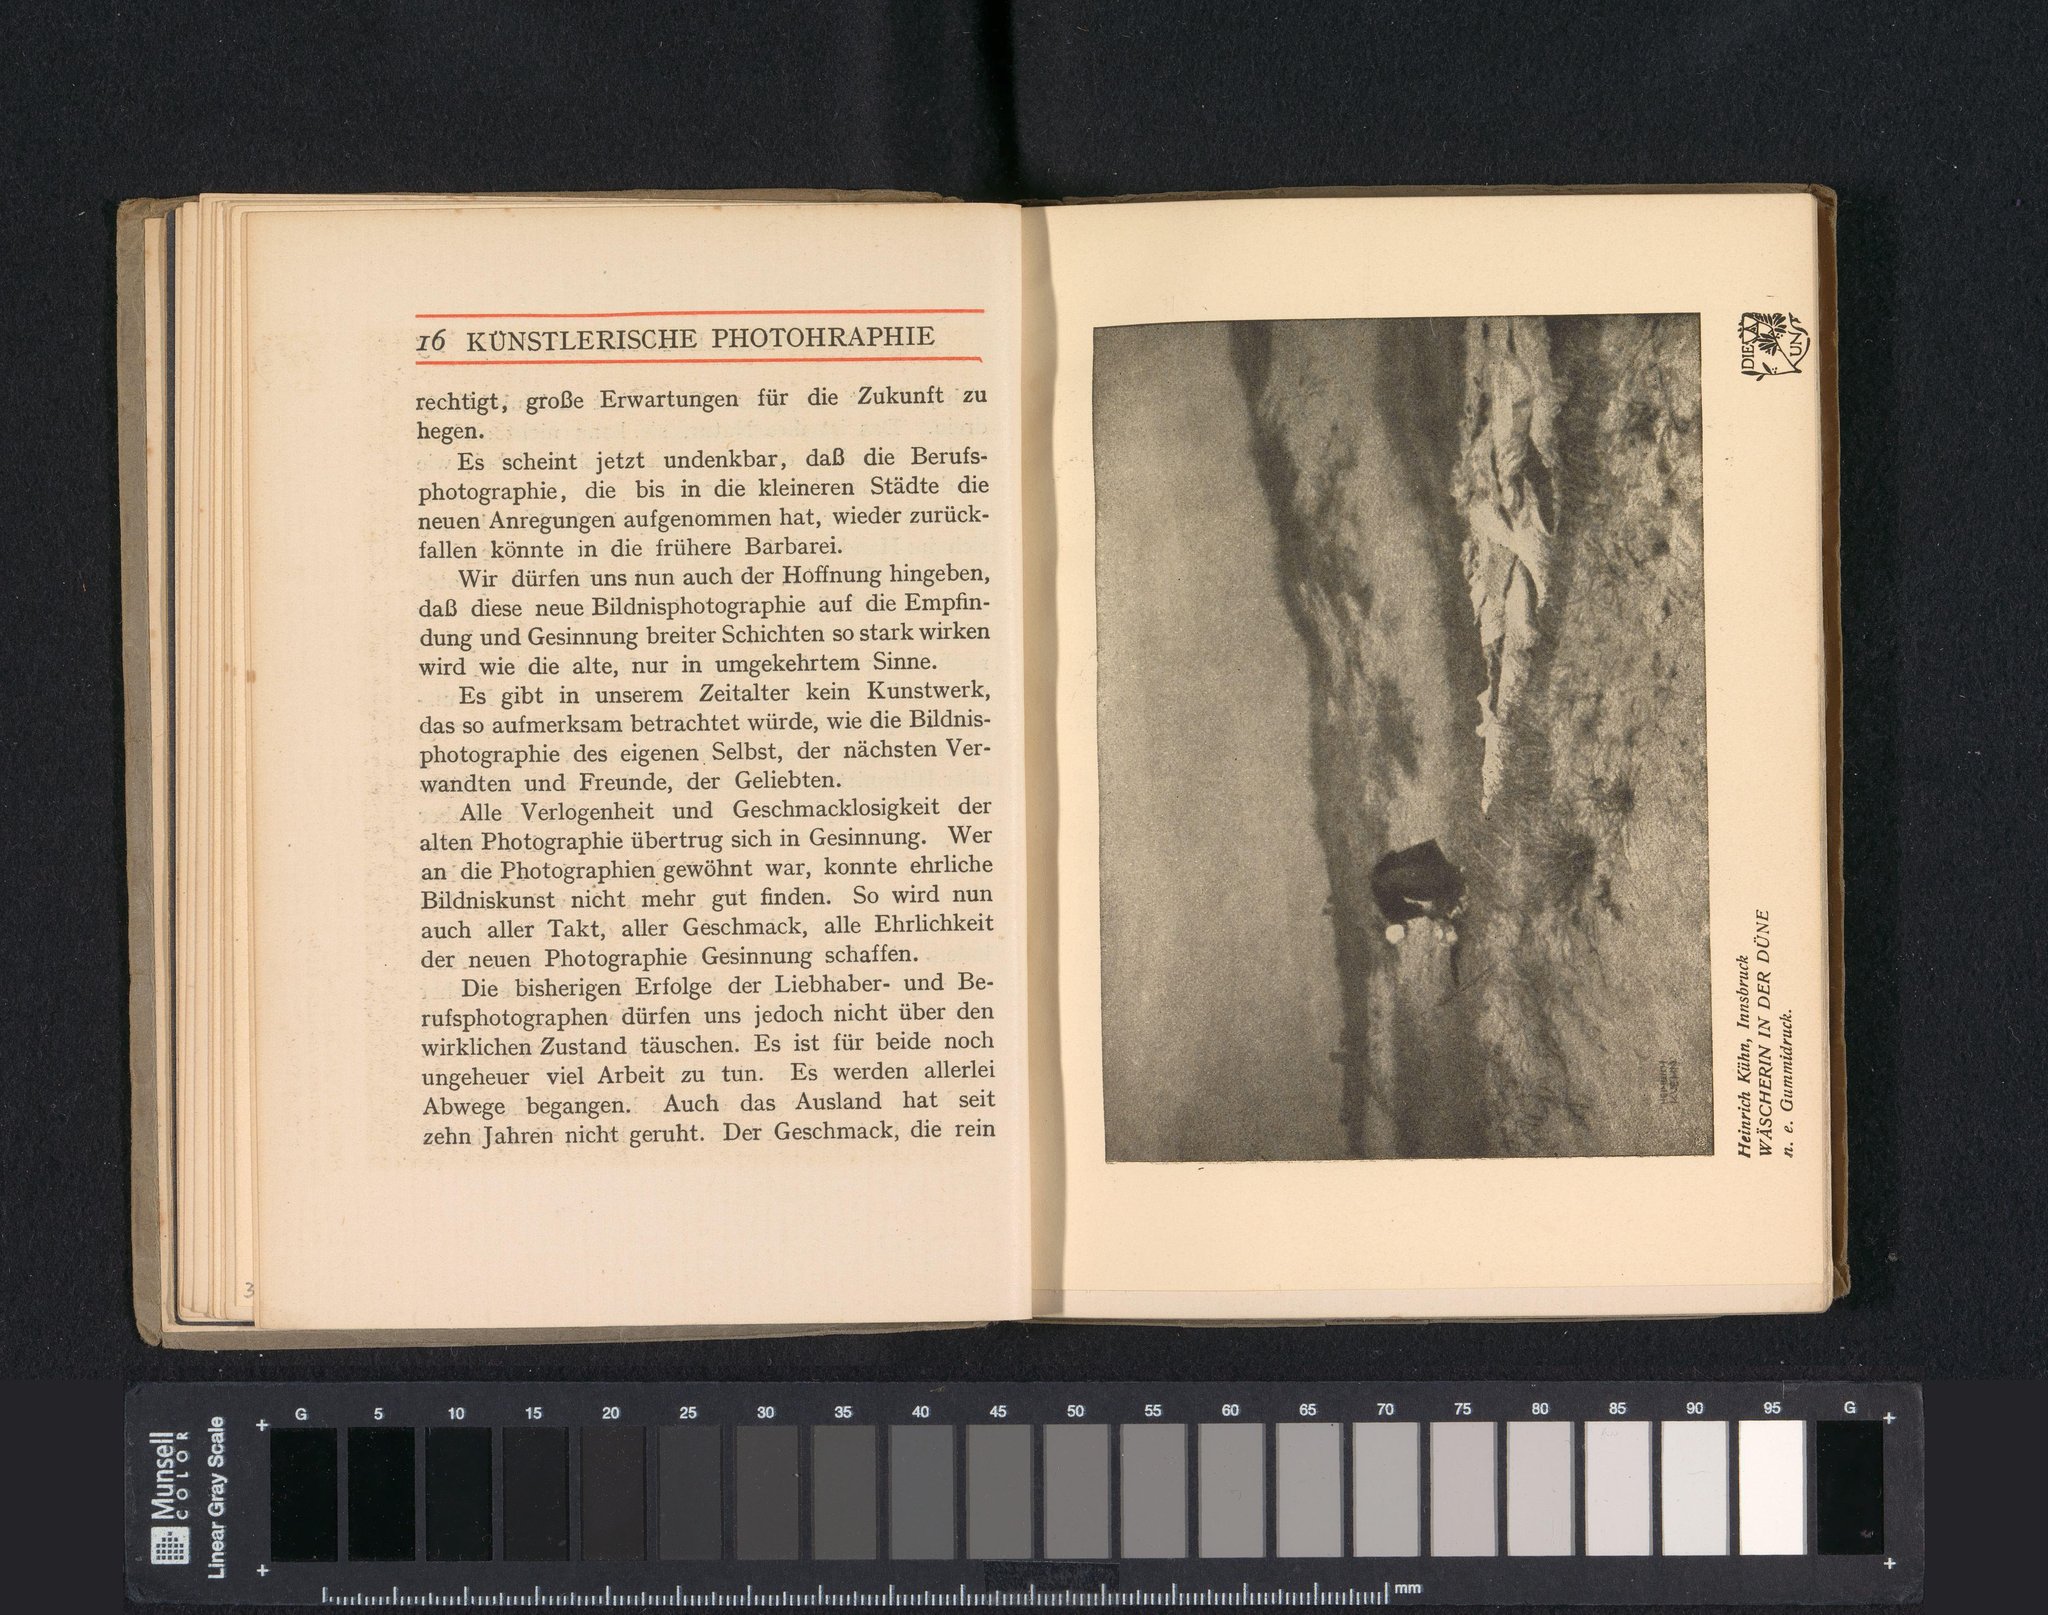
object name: page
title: Fotoreproductie van een foto door Heinrich Kühn, voorstellend een wasvrouw in de duinen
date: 1880-1907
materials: paper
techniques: autotype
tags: dunes (sea not visible); in the dunes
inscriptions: inscription: ‘n.e. Gummidruck.’